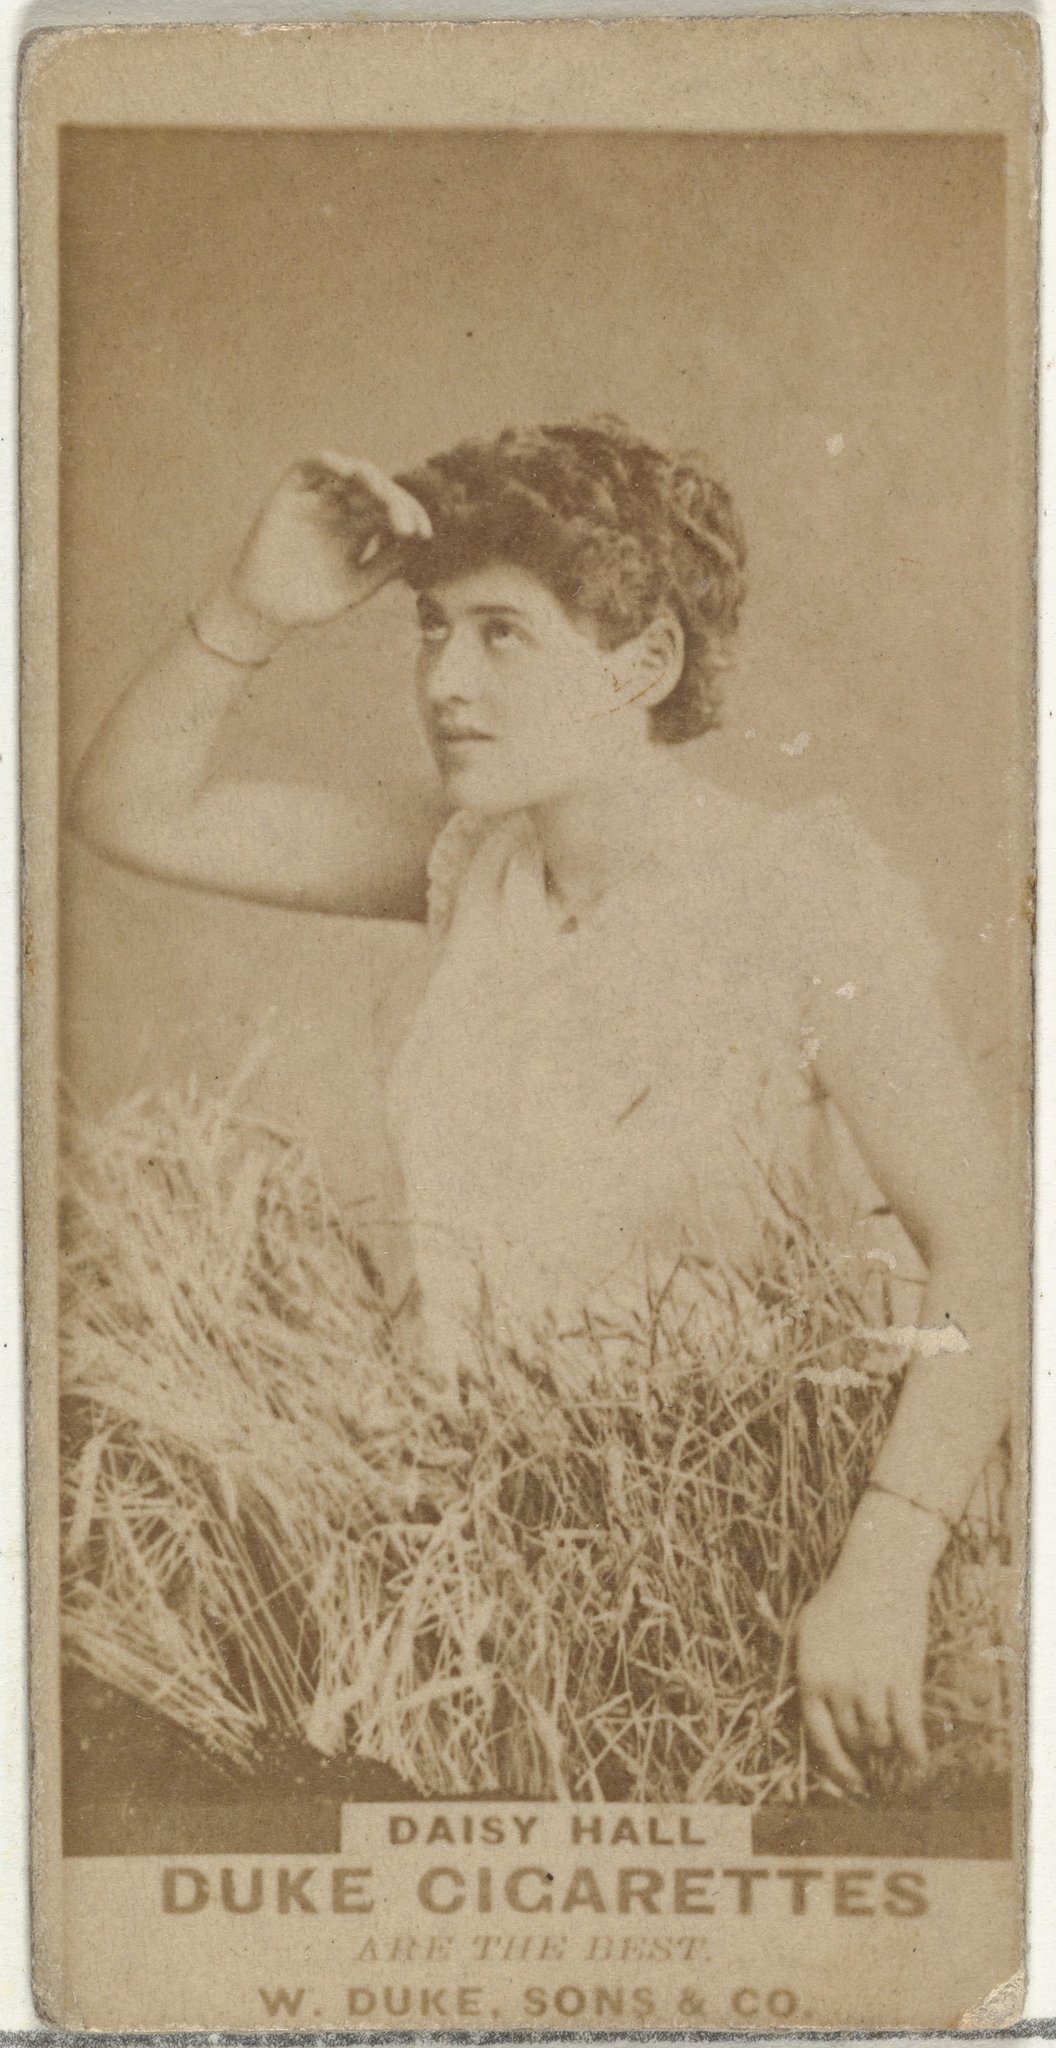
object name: photograph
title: Daisy Hall, from the Actors and Actresses series (N145-7) issued by Duke Sons & Co. to promote Duke Cigarettes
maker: w. duke, sons & co.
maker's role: publisher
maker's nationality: american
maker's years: 1870-1920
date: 1880-1889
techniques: albumen silver print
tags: portraits,women,actresses